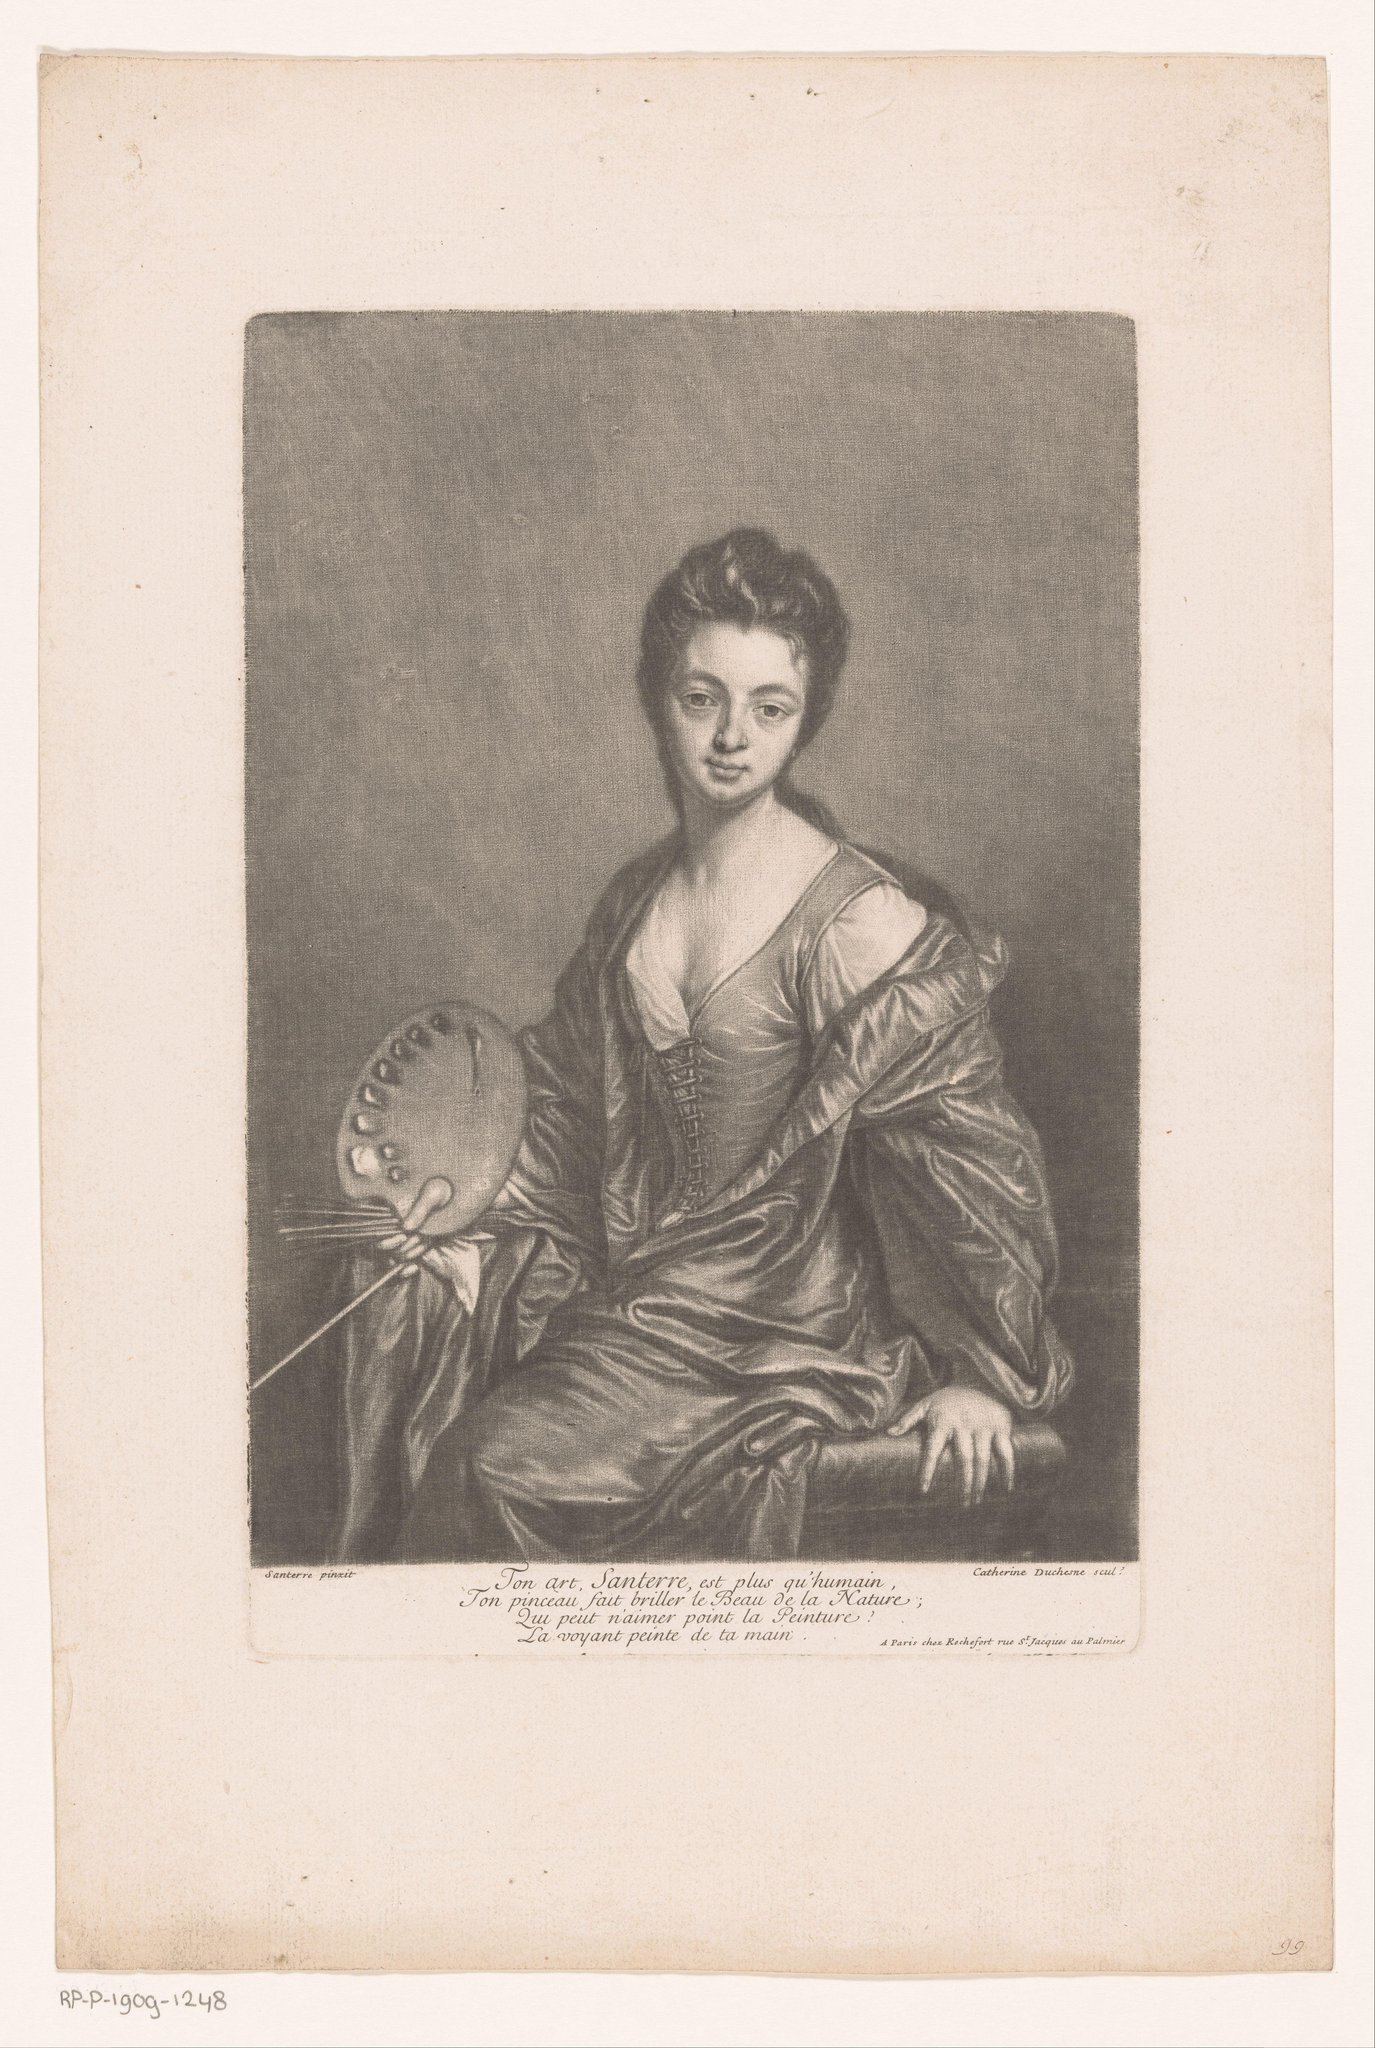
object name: print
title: Portret van Geneviève Blanchot als Schilderkunst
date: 1745-1755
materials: paper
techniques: mezzotint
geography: paris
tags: 'pictura', symbolic representations, allegories and emblems ~ painting; 'pittura' (ripa), historical persons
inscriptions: collector's mark: Lugt 2228